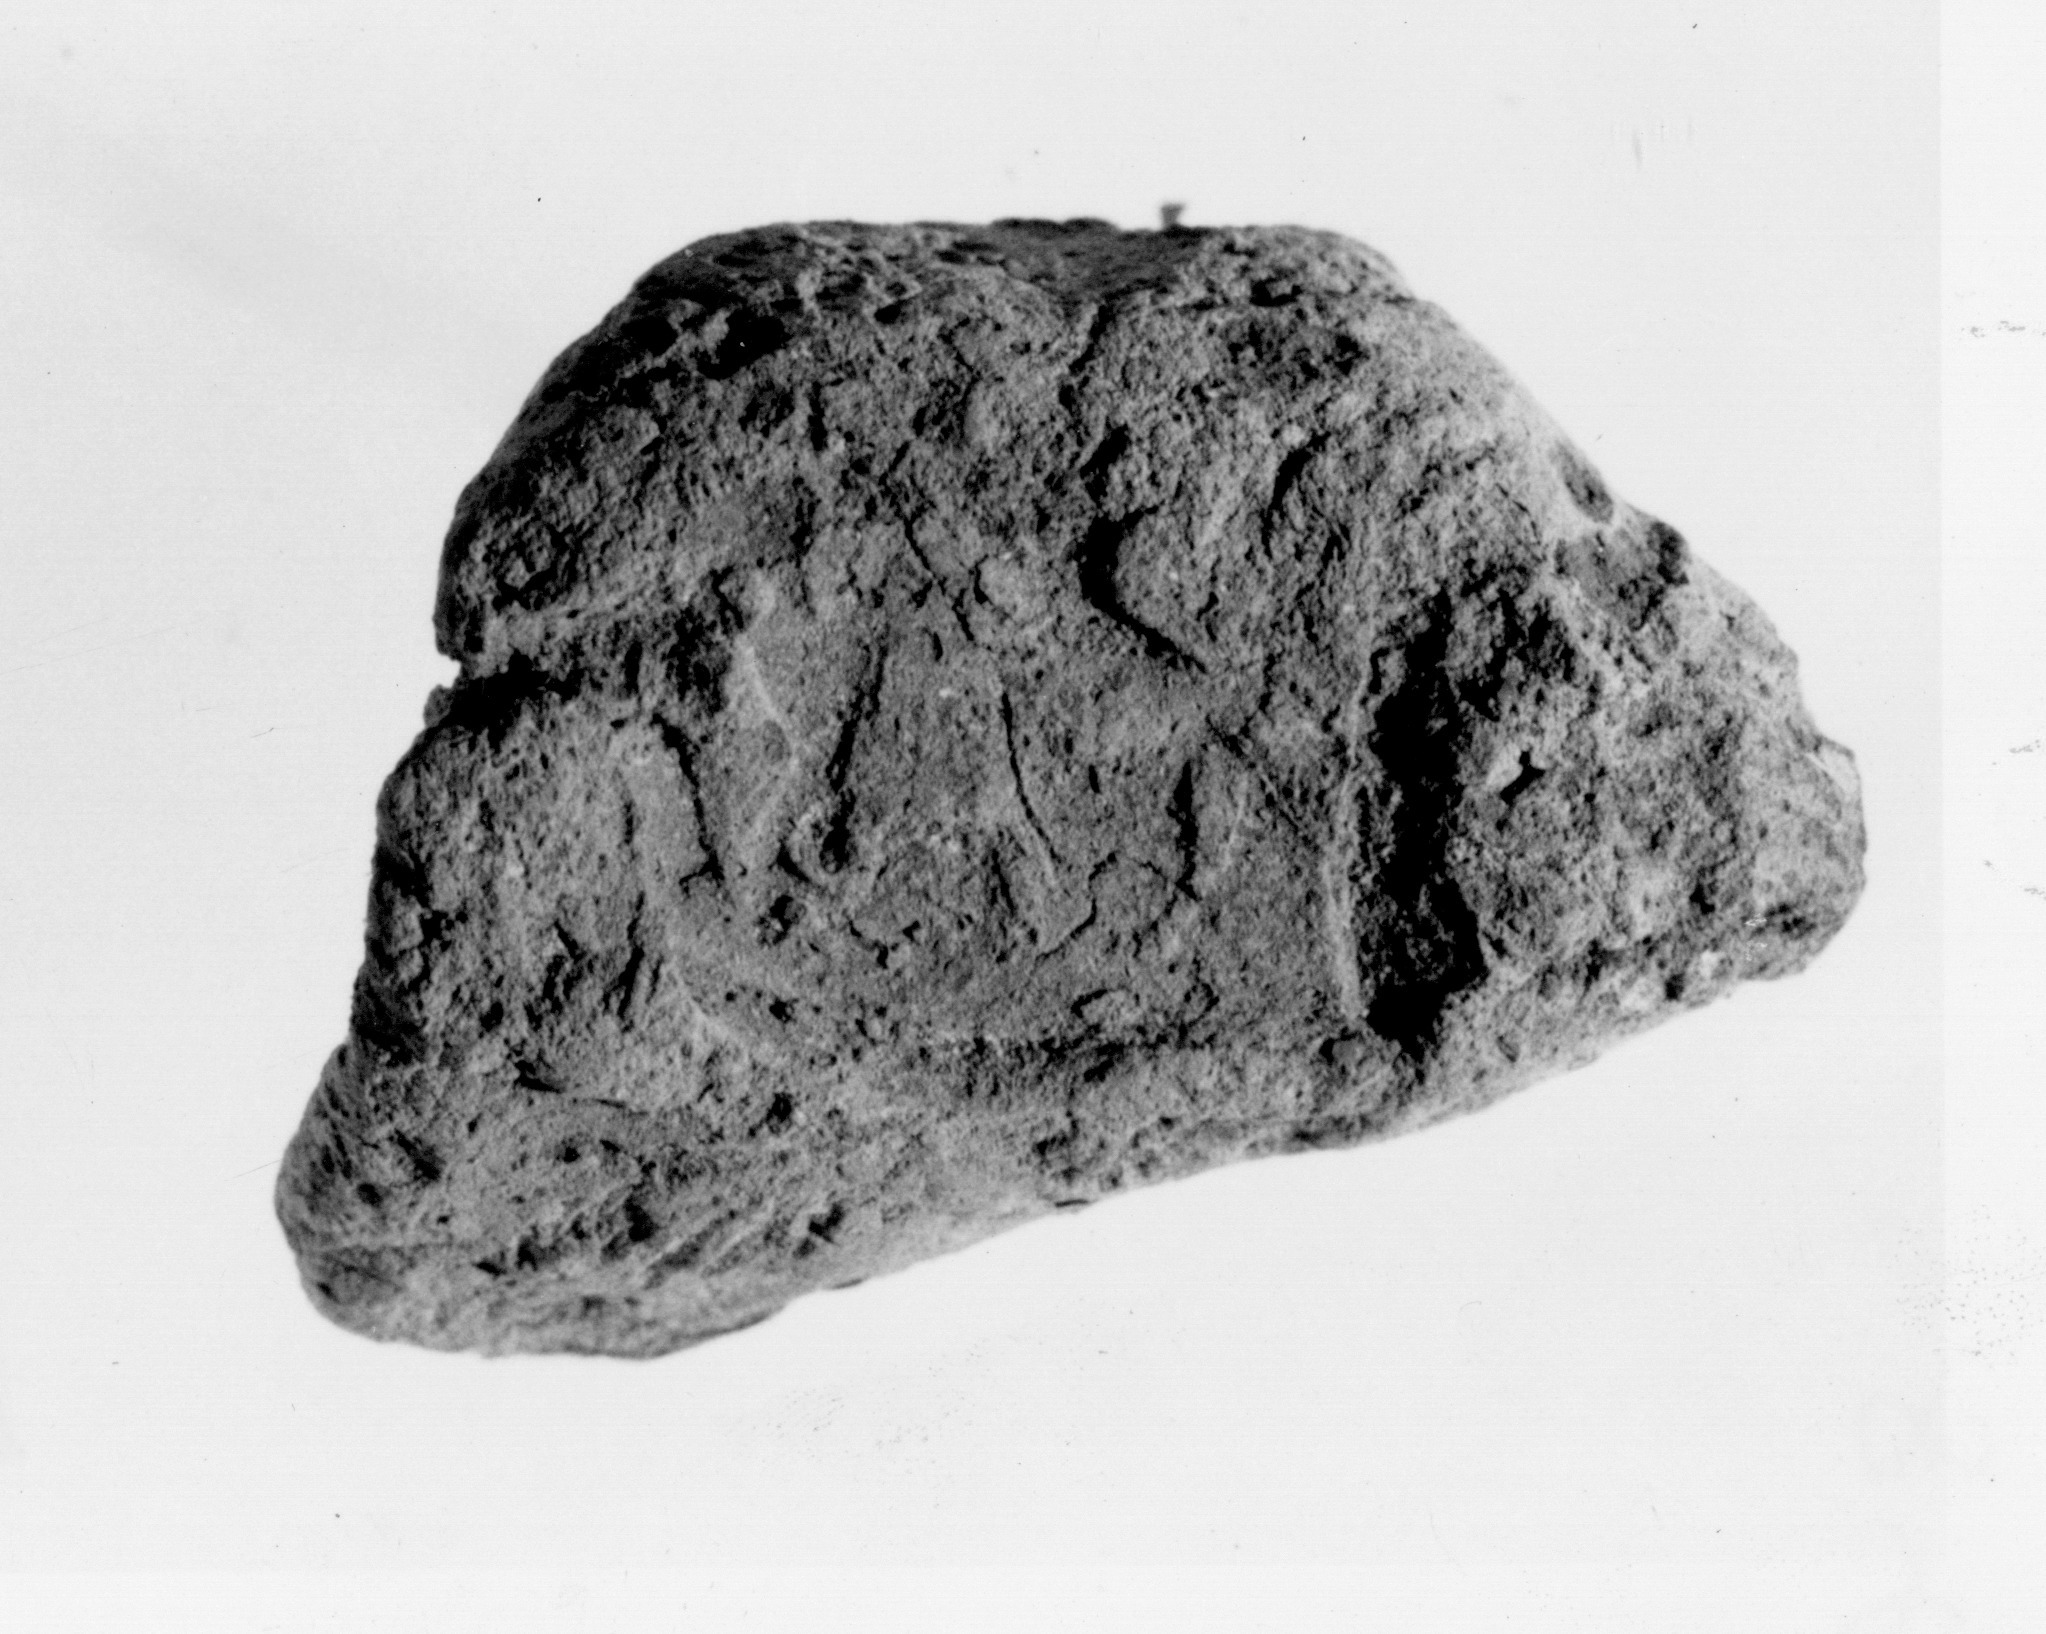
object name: sealing, walking lion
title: Document Sealing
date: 1390-1352 BCE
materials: mud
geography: egypt